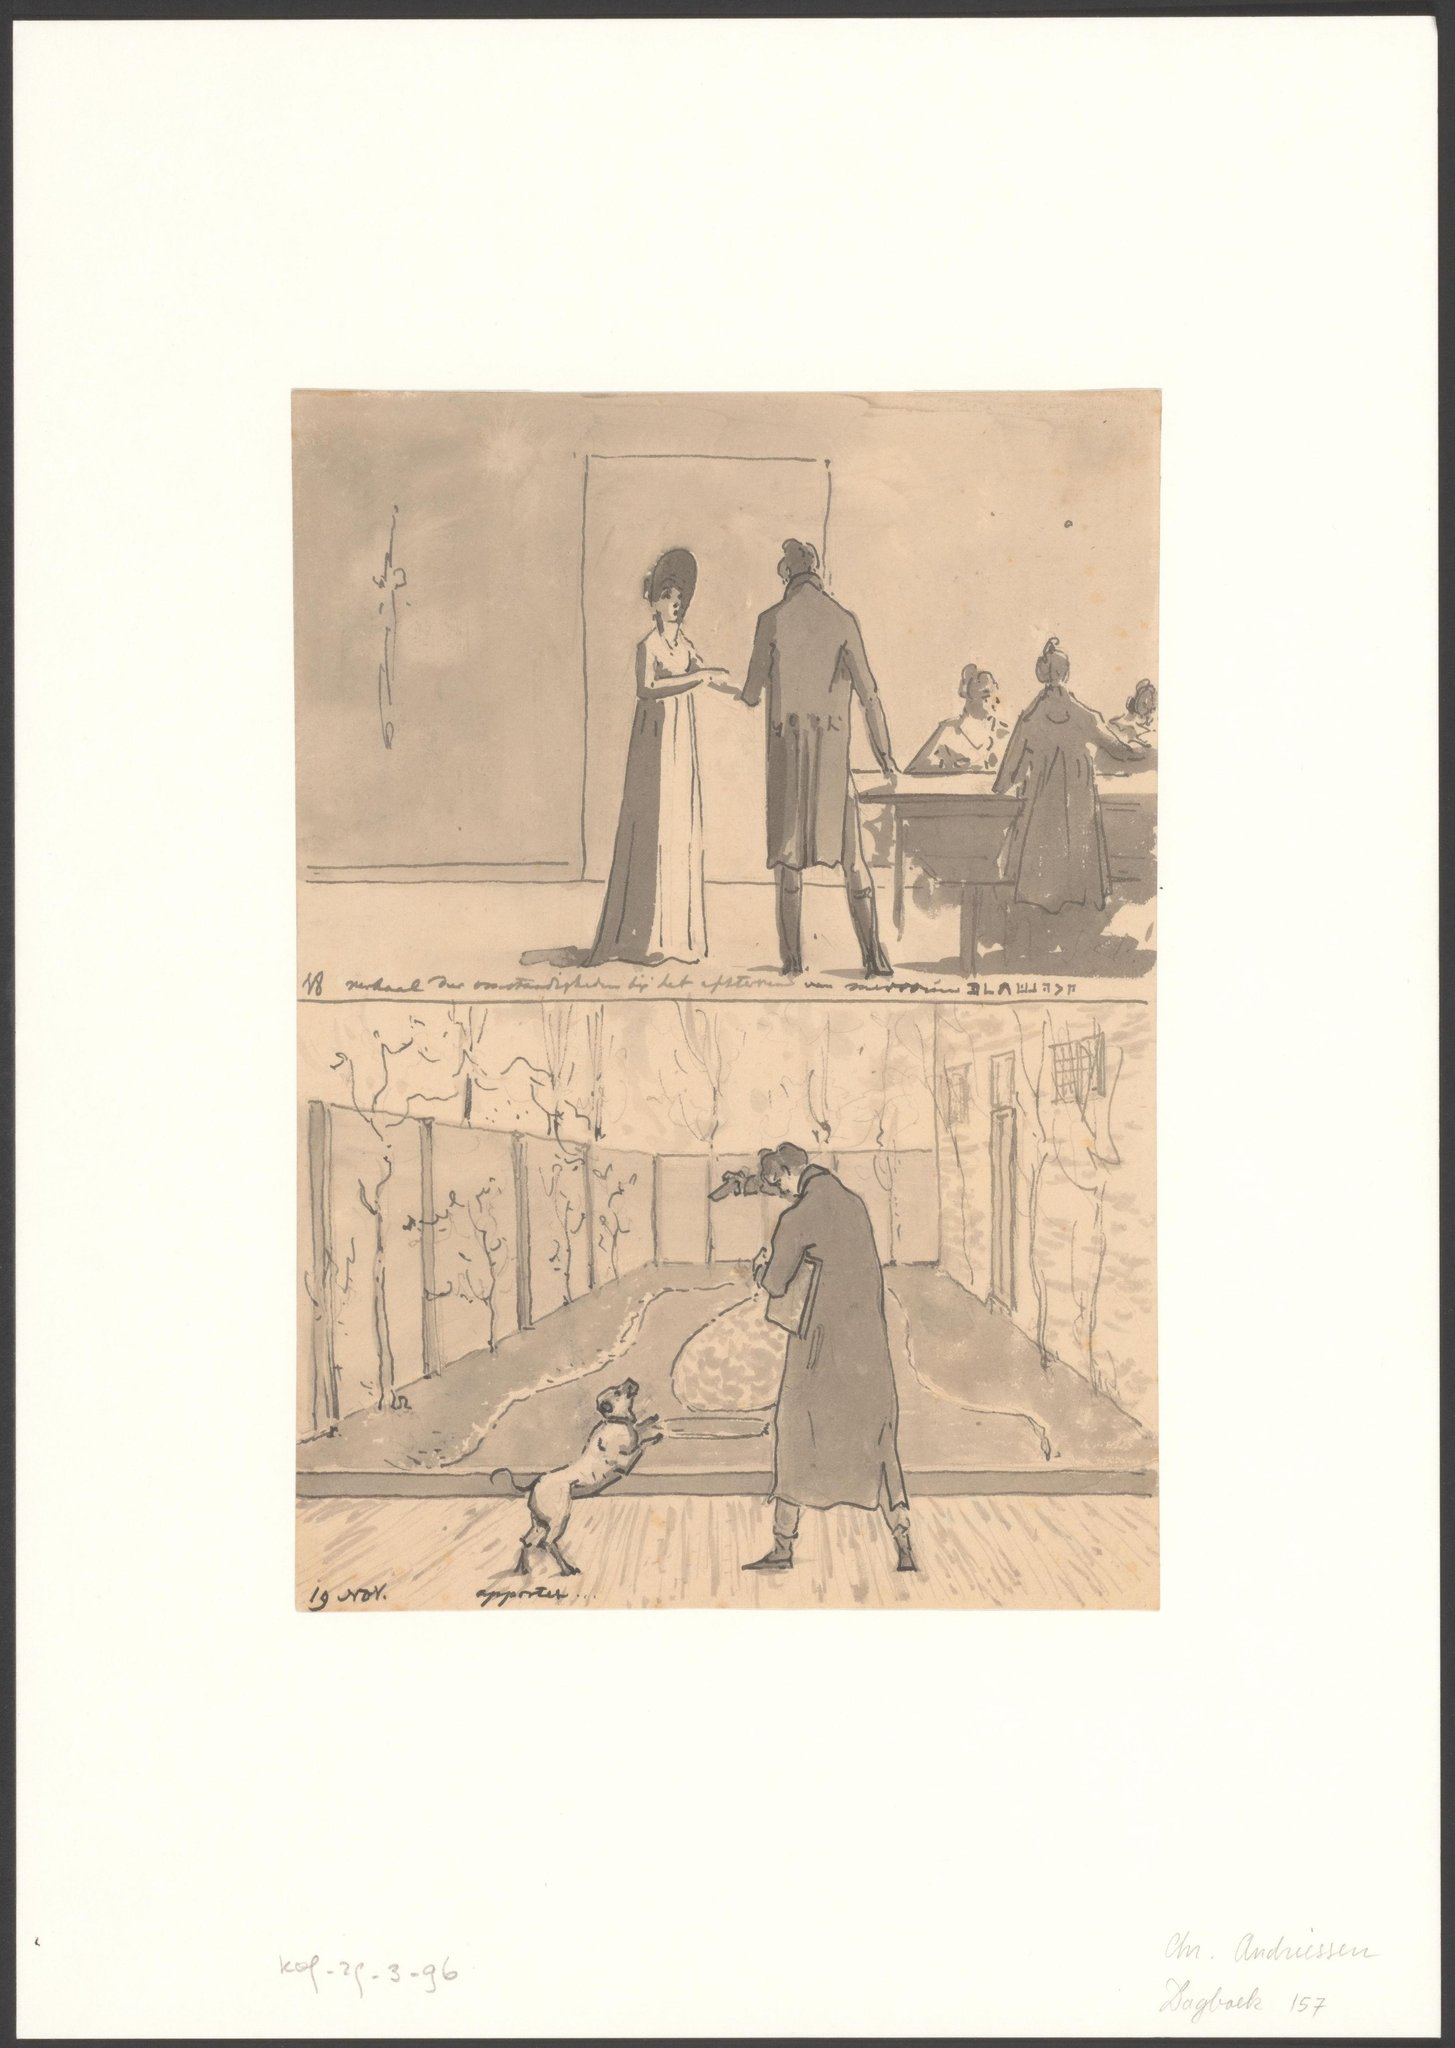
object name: drawing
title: Twee scènes uit het leven van Christiaan Andriessen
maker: christiaan andriessen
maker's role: draughtsman, print maker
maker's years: 1775-1846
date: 1805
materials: ink, paper, pencil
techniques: brush, pen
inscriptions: inscription: ‘18 nov. verhaal der omstandigheden bij het afsterven van mevrouw Heijdanur / 19 nov. apportez..’, signature: ‘J Andriessen’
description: Op 18 november gaat het gesprek over het overlijden van een bekende en op 19 november speelt Christiaan Andriessen met de hond in de tuin van Amstel 95.